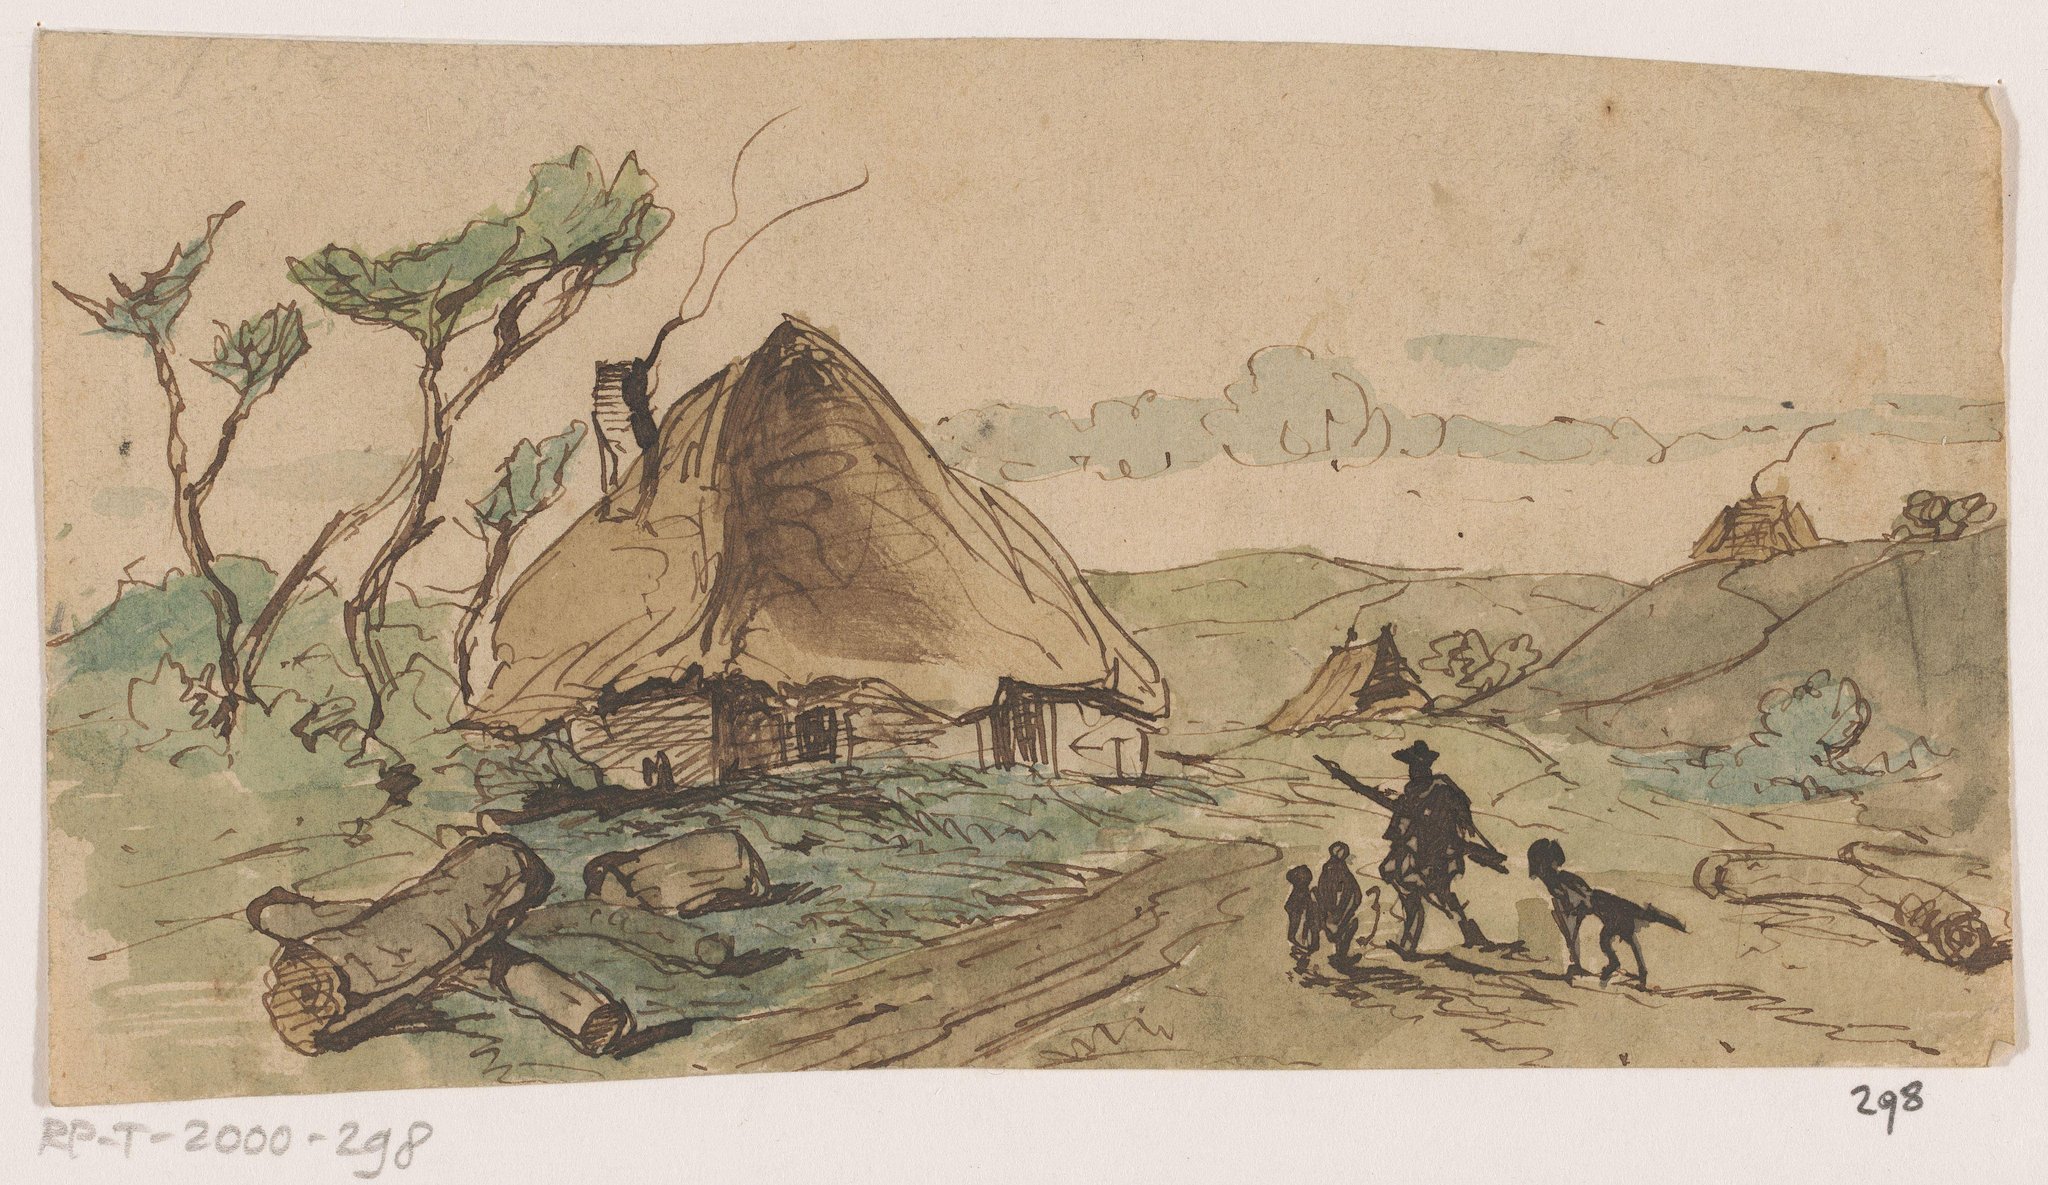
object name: drawing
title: Jager tussen huizen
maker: johannes tavenraat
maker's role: draughtsman, painter, print maker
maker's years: 1809-1881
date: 1840-1880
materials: ink, paper, watercolor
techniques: brush, pen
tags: hunter, public road in village (+ city(-scape) with figures, staffage)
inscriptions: collector's mark: Lugt 2228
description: Een jager met hond en twee kinderen, in een dorp tussen huizen.